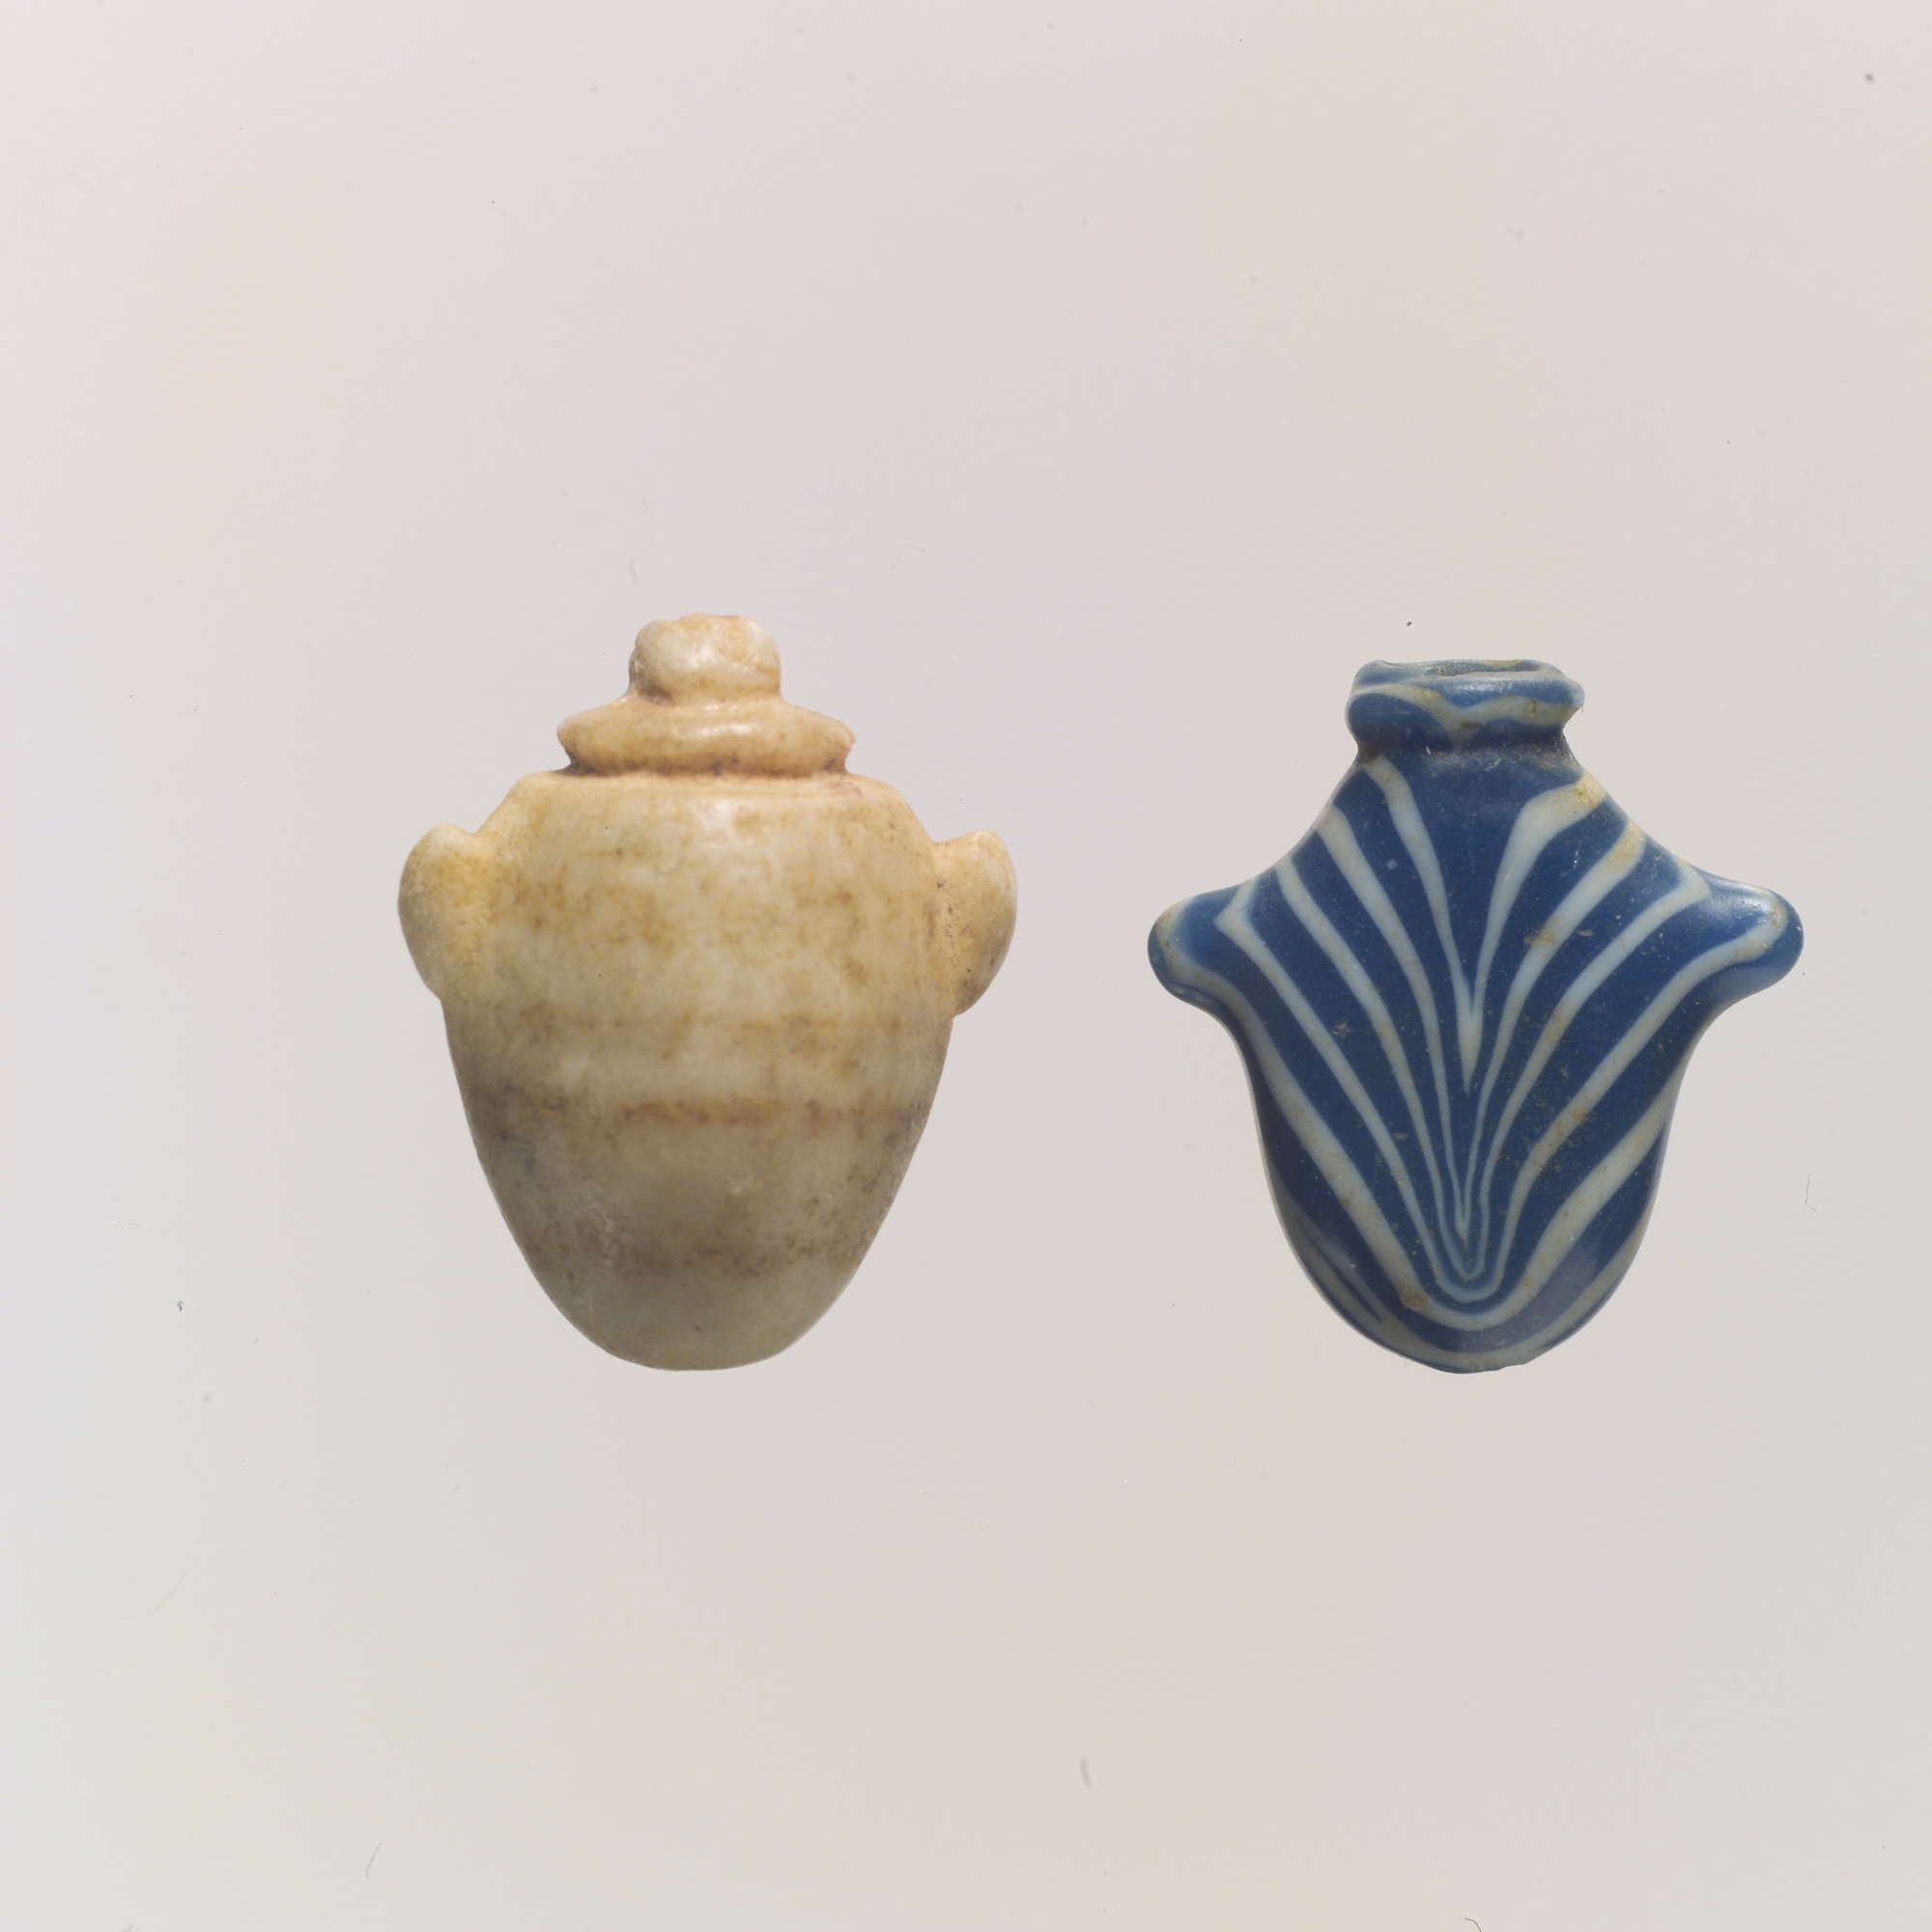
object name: amulet, heart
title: Heart amulets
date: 1550-1186 BCE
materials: stone, glass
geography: egypt